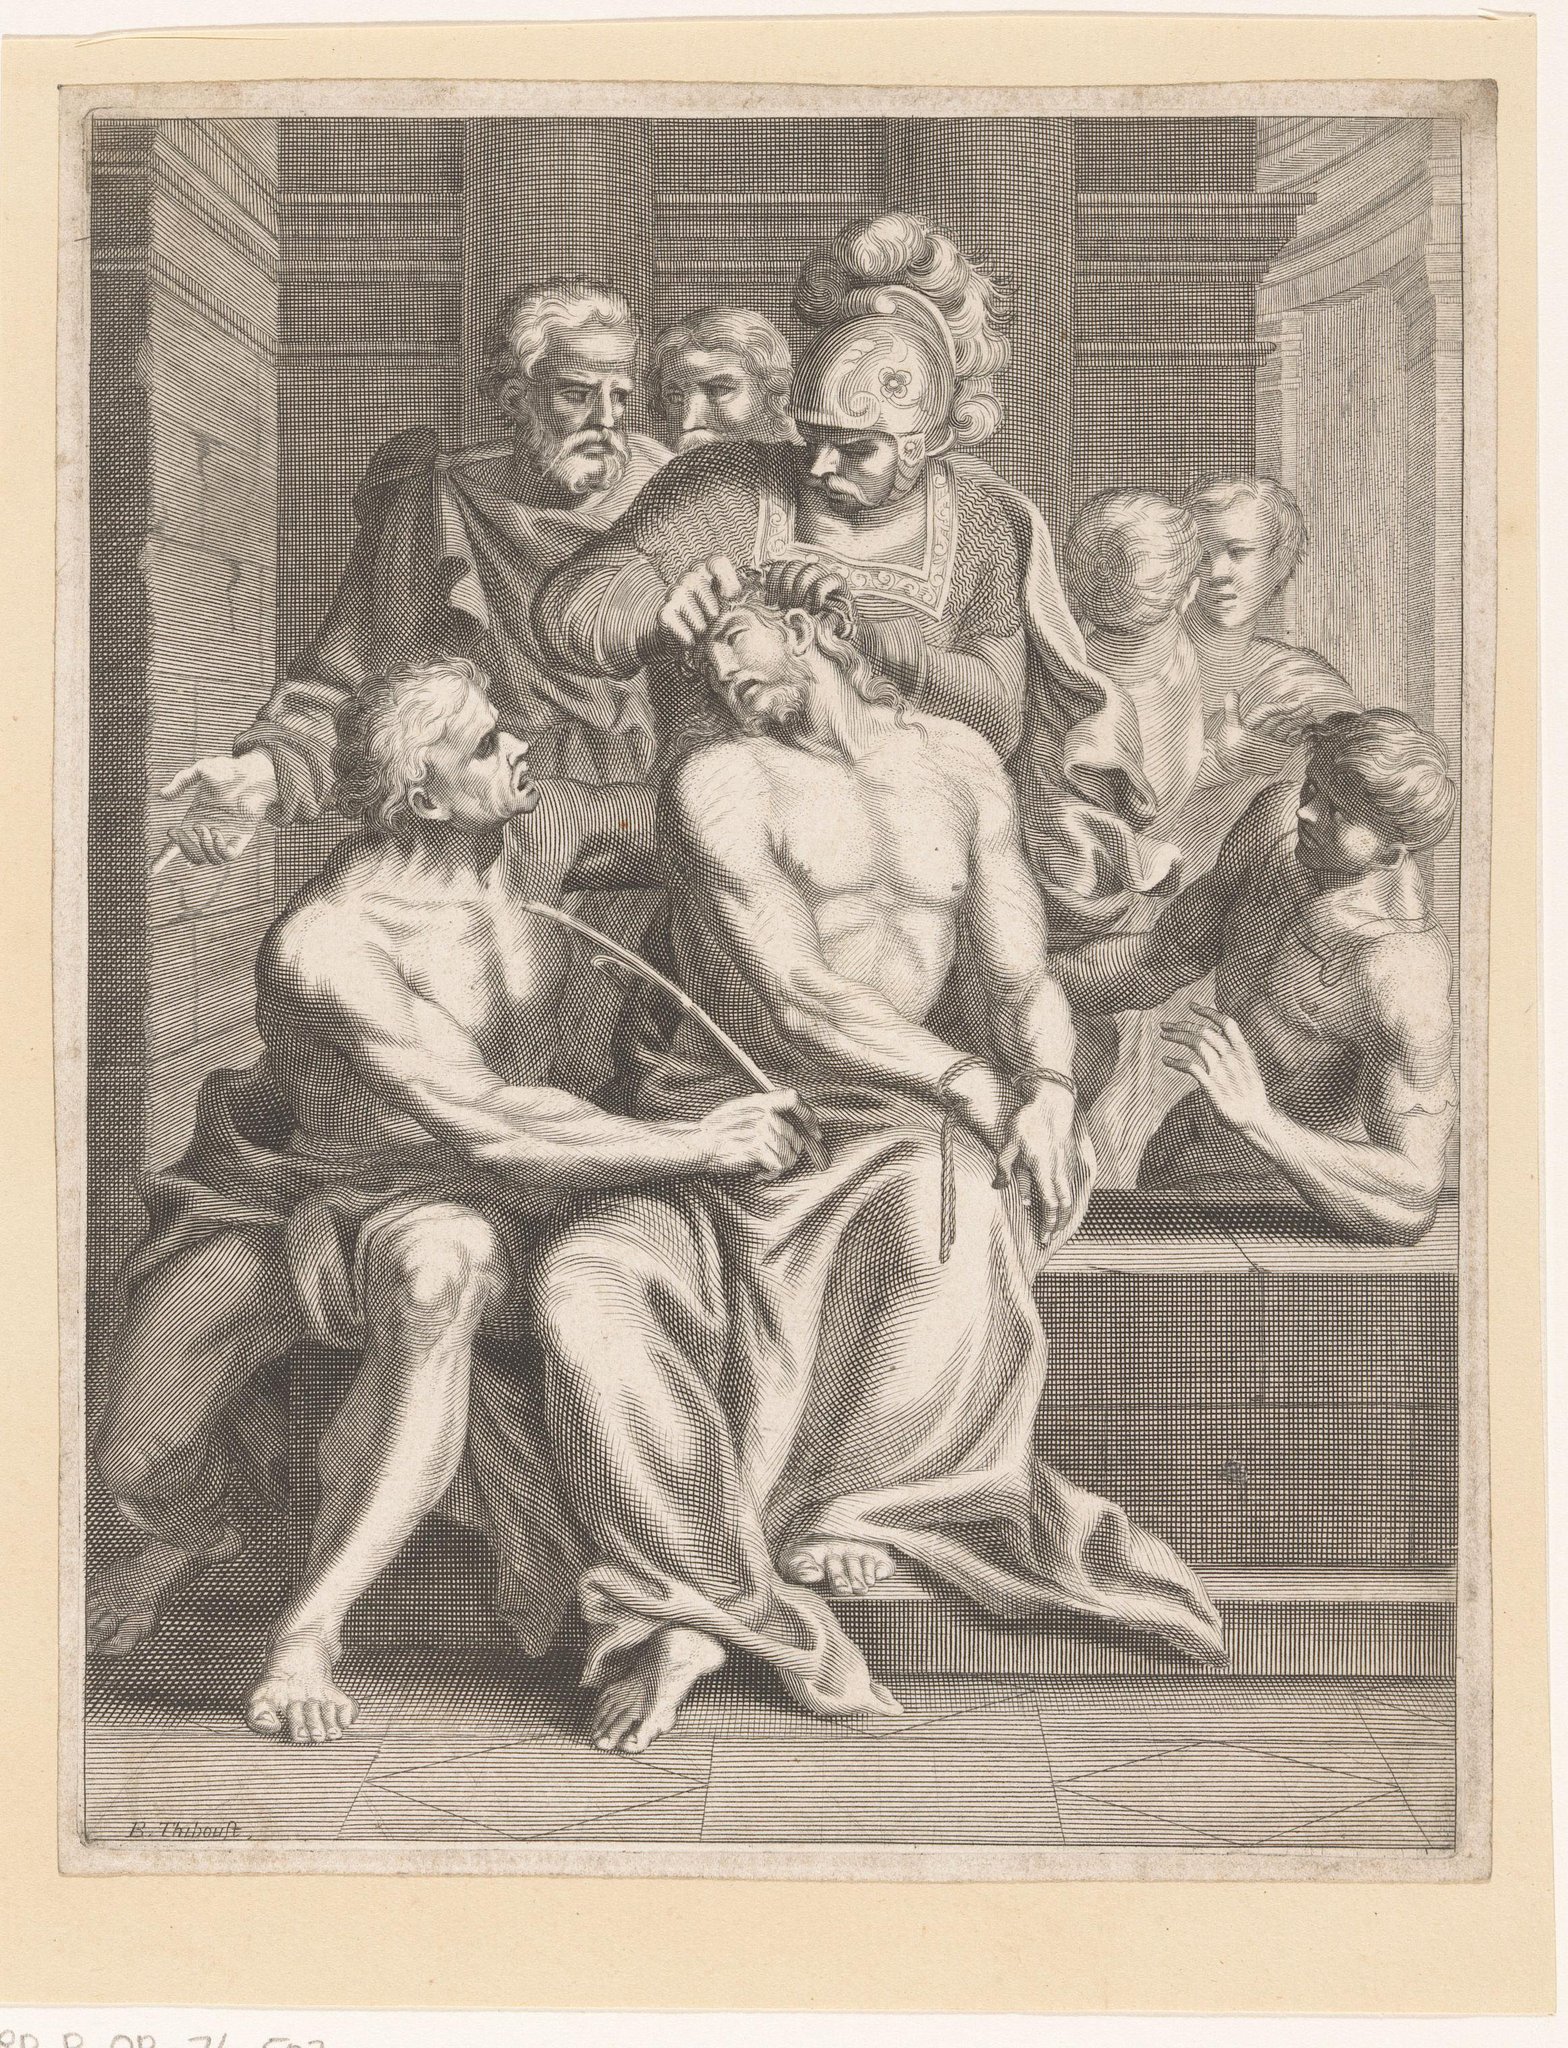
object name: print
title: Doornenkroning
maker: benoît thiboust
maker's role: print maker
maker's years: 1619-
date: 1629-1729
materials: paper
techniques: engraving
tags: the crowning with thorns: soldiers with sticks place a thorny crown on christ's head and give him a reed (matthew 27:27-31; mark 15:16-20; john 19:2-3)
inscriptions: collector's mark: Lugt 240